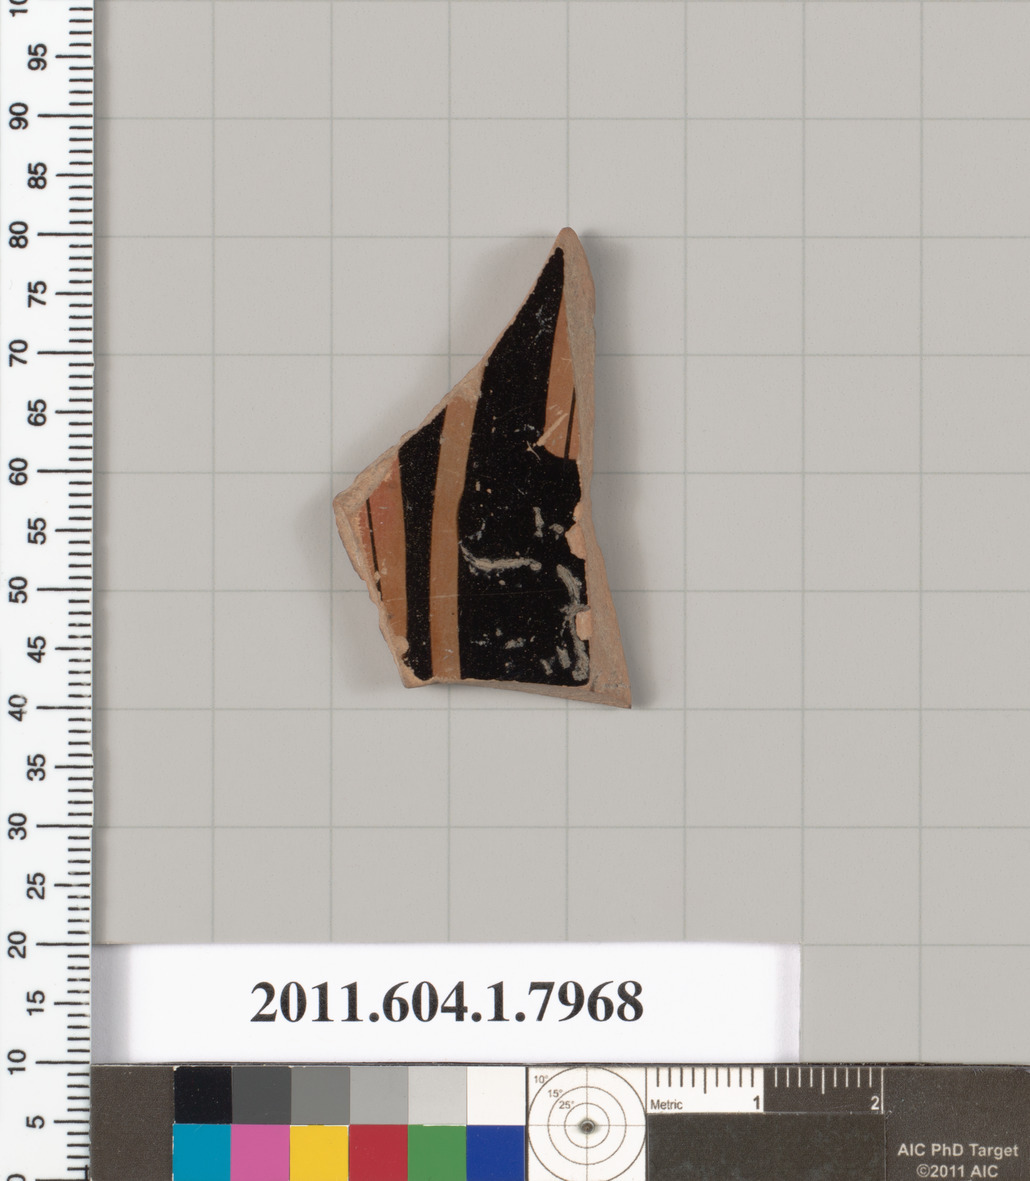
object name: kylix fragment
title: Terracotta fragment of a kylix (drinking cup)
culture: greek, attic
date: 460-450 BCE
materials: terracotta